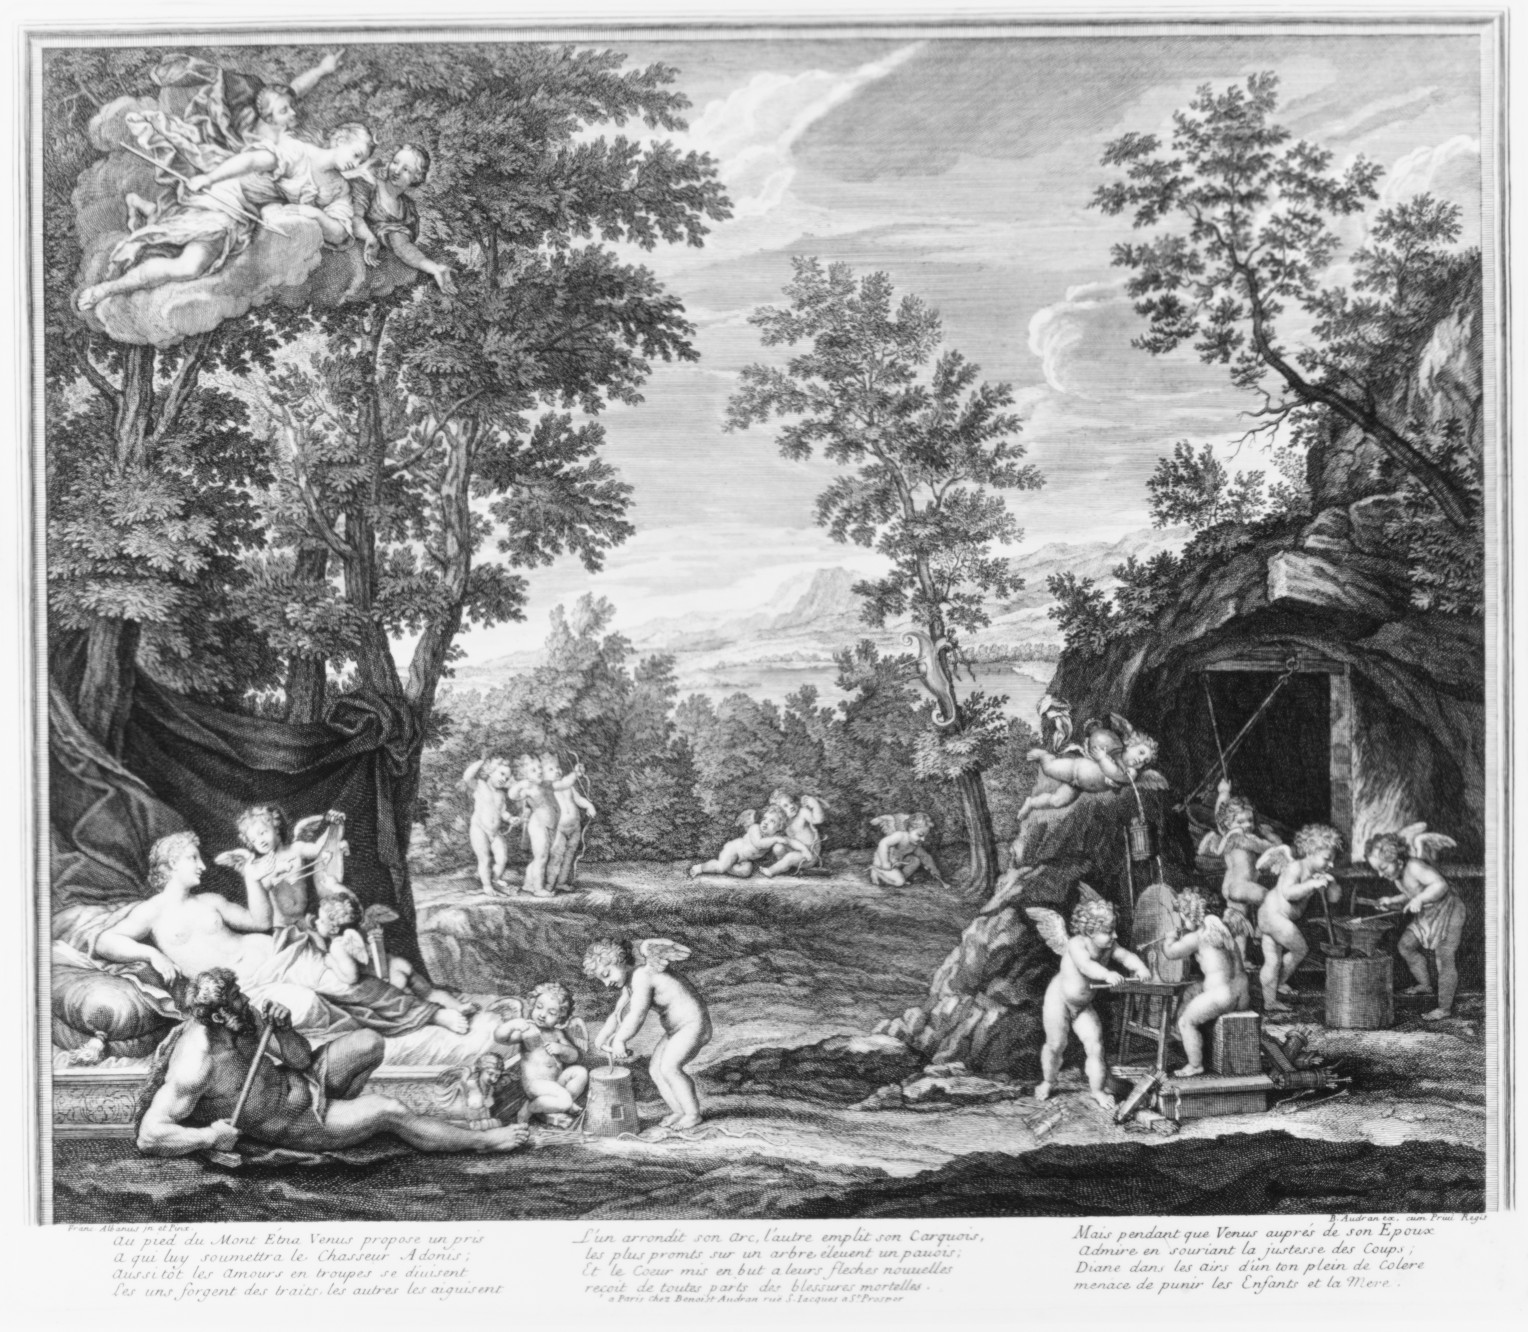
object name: print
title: The Loves of Venus and Adonis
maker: francesco albani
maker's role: artist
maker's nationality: italian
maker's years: 1578-1660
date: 1741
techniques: engraving, etching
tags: adonis,venus